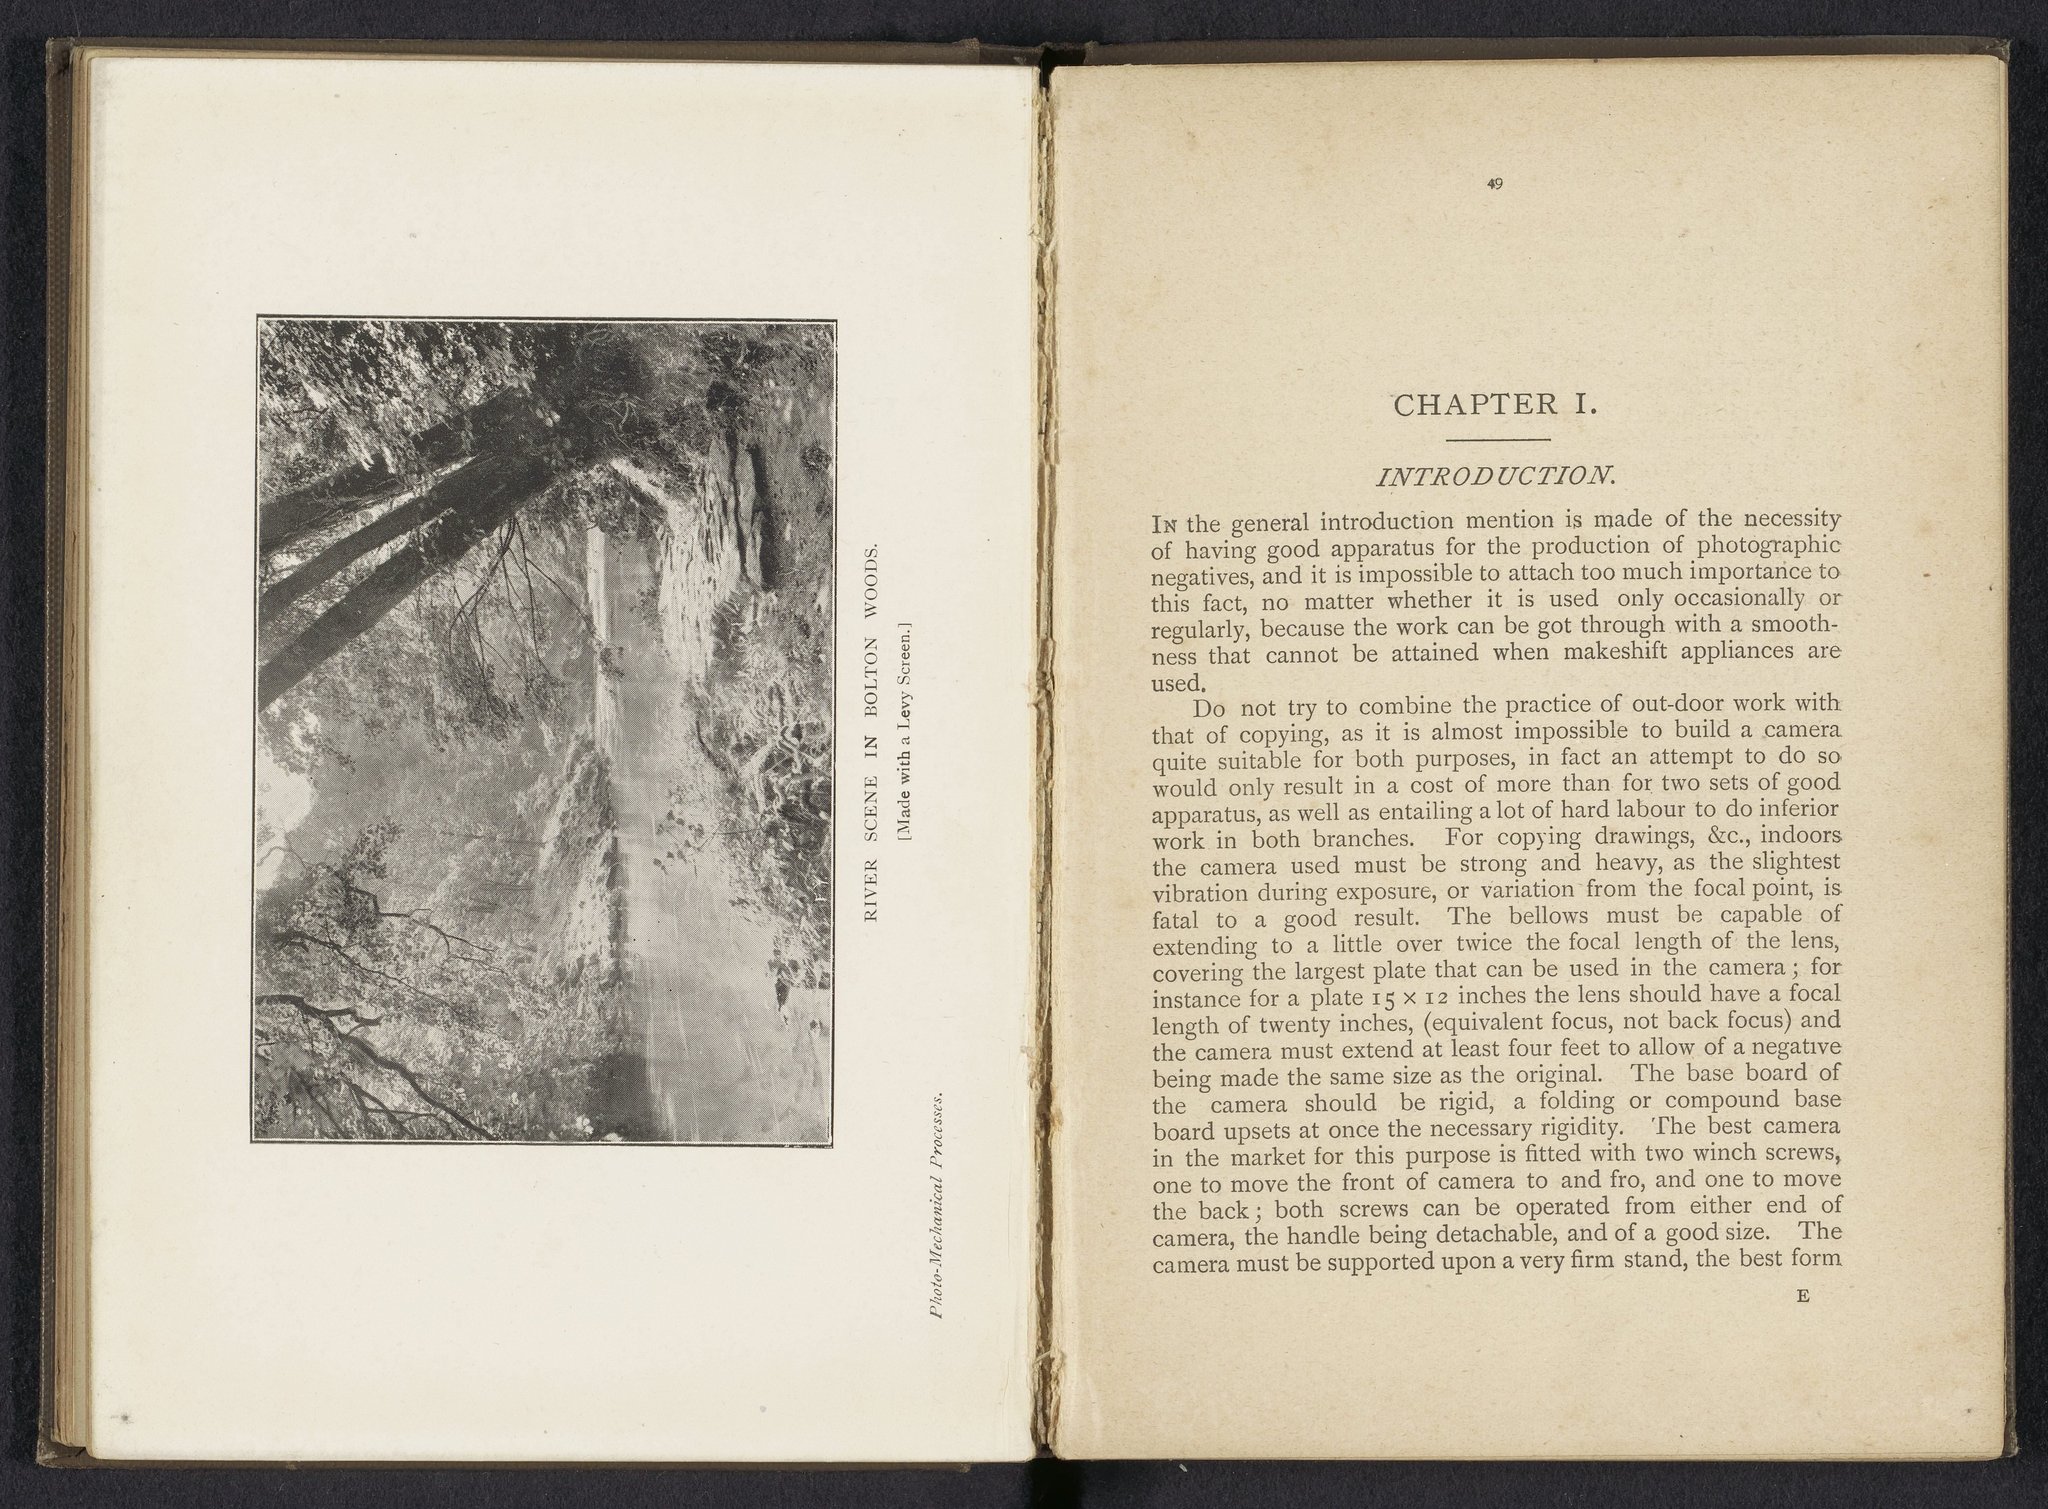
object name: photomechanical print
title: River scene in Bolton woods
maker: Anonymous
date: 1887-1897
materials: paper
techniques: autotype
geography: bolton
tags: river, forest, wood